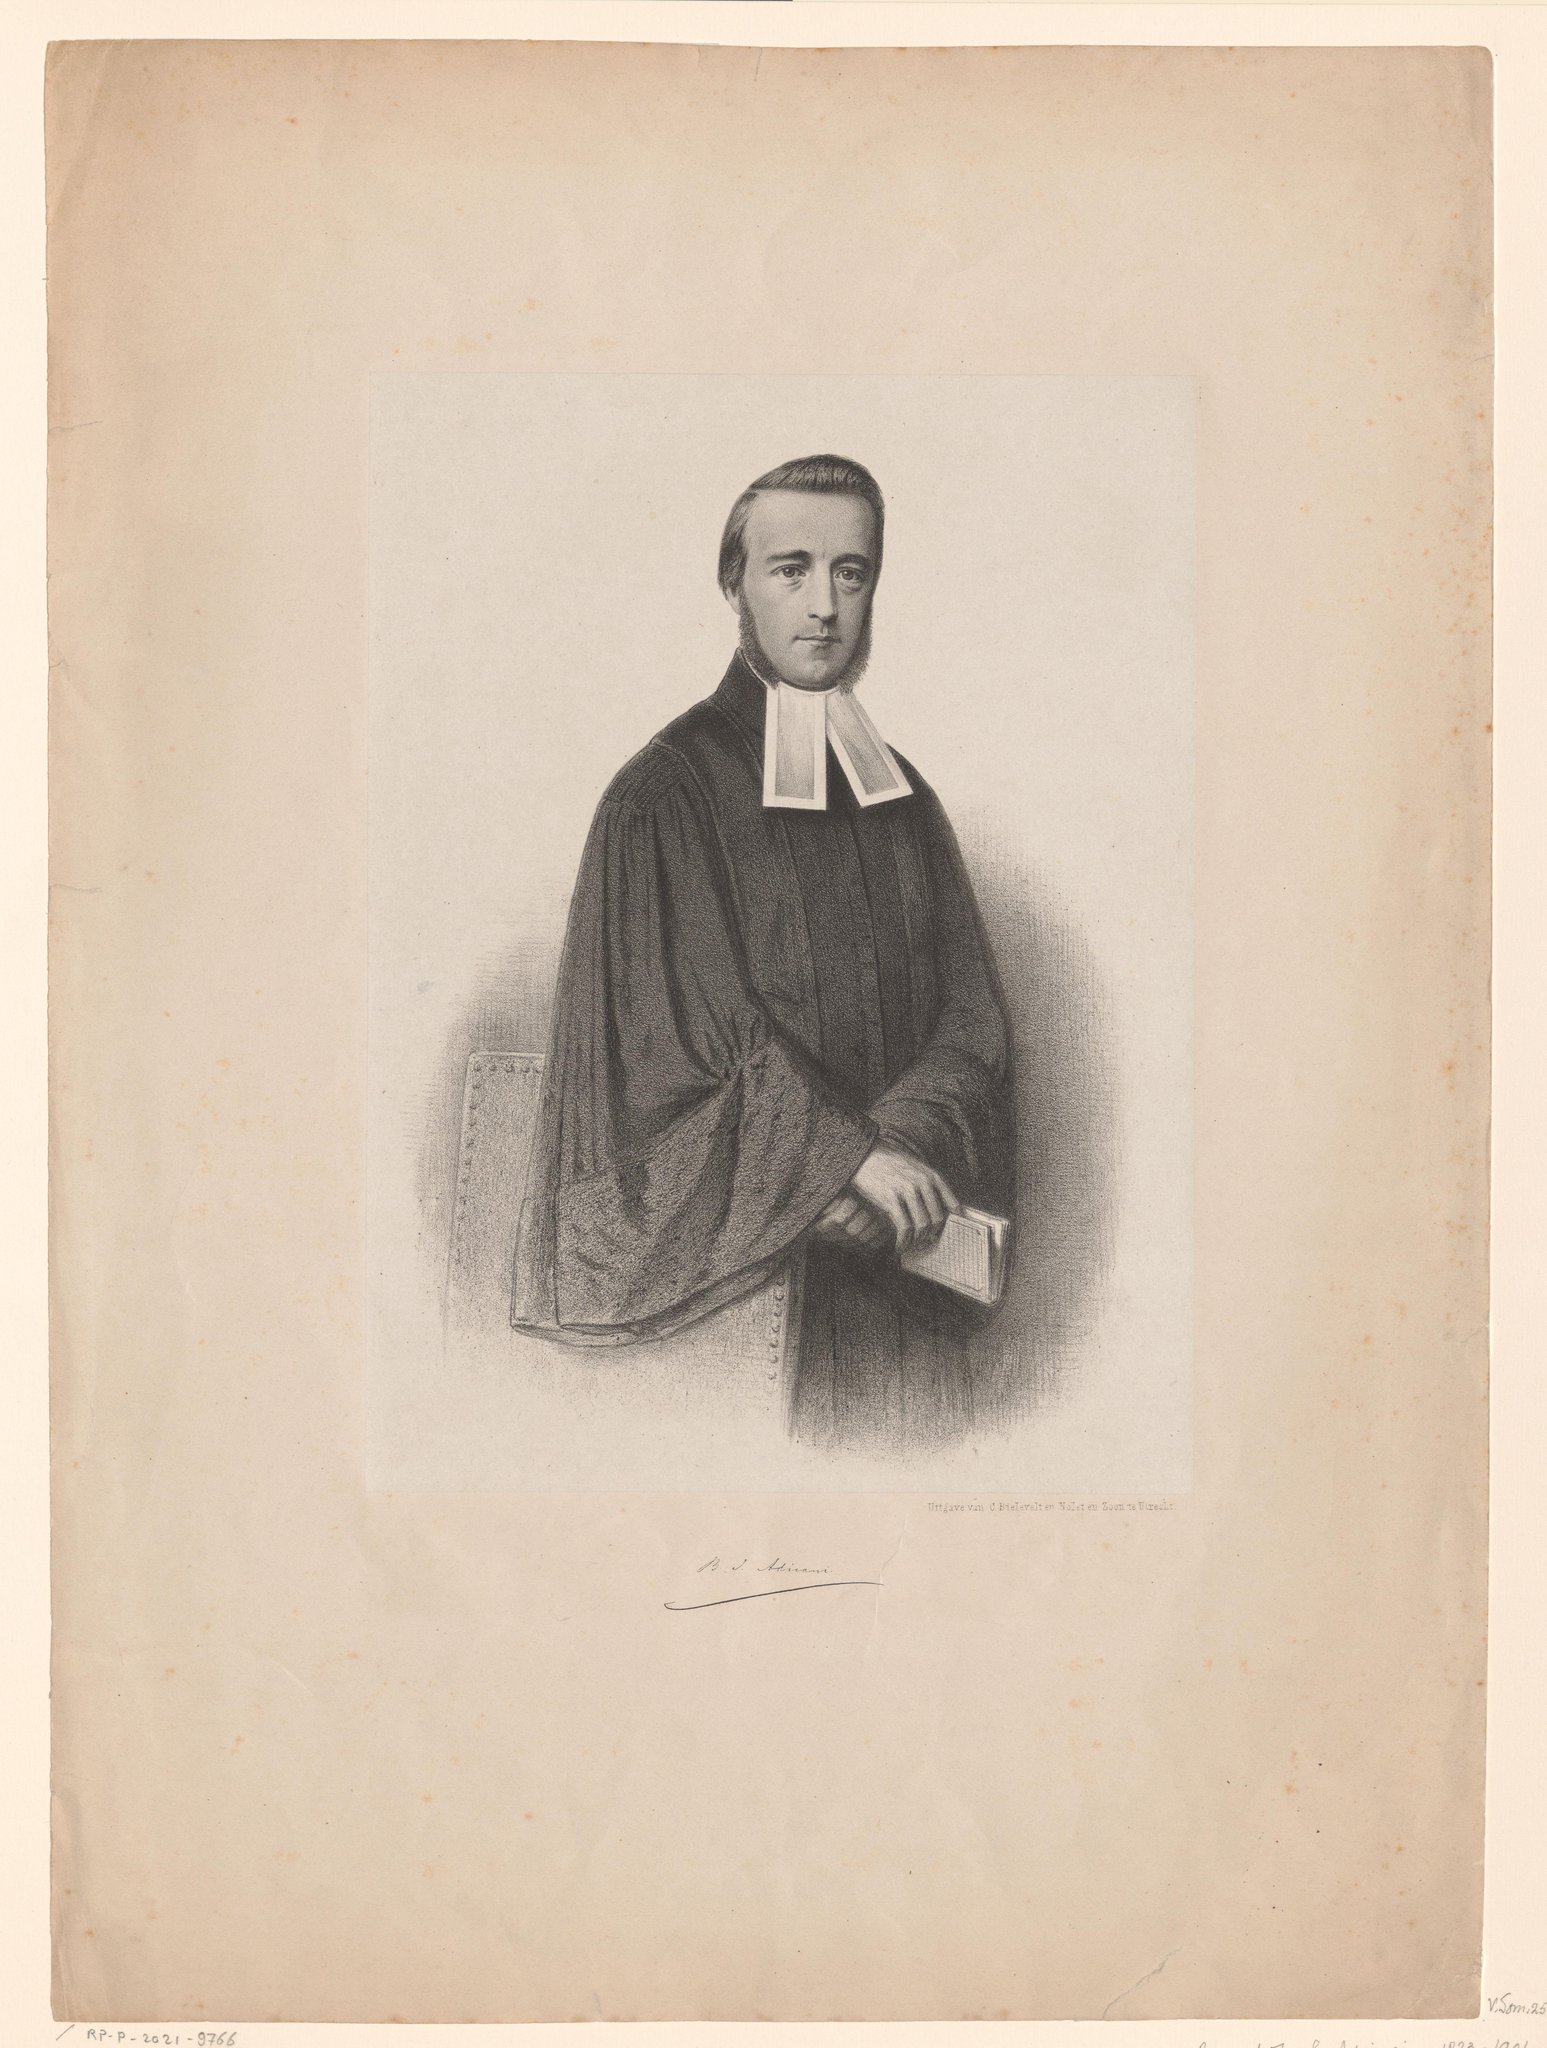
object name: print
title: Portret van Bernard Jacob Adriani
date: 1843-1872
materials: paper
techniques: lithograph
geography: utrecht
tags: amsterdam, clergyman, historical persons, functionaries and dignitaries ~ episcopal protestant churches, book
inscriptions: collector's mark: Lugt 2228